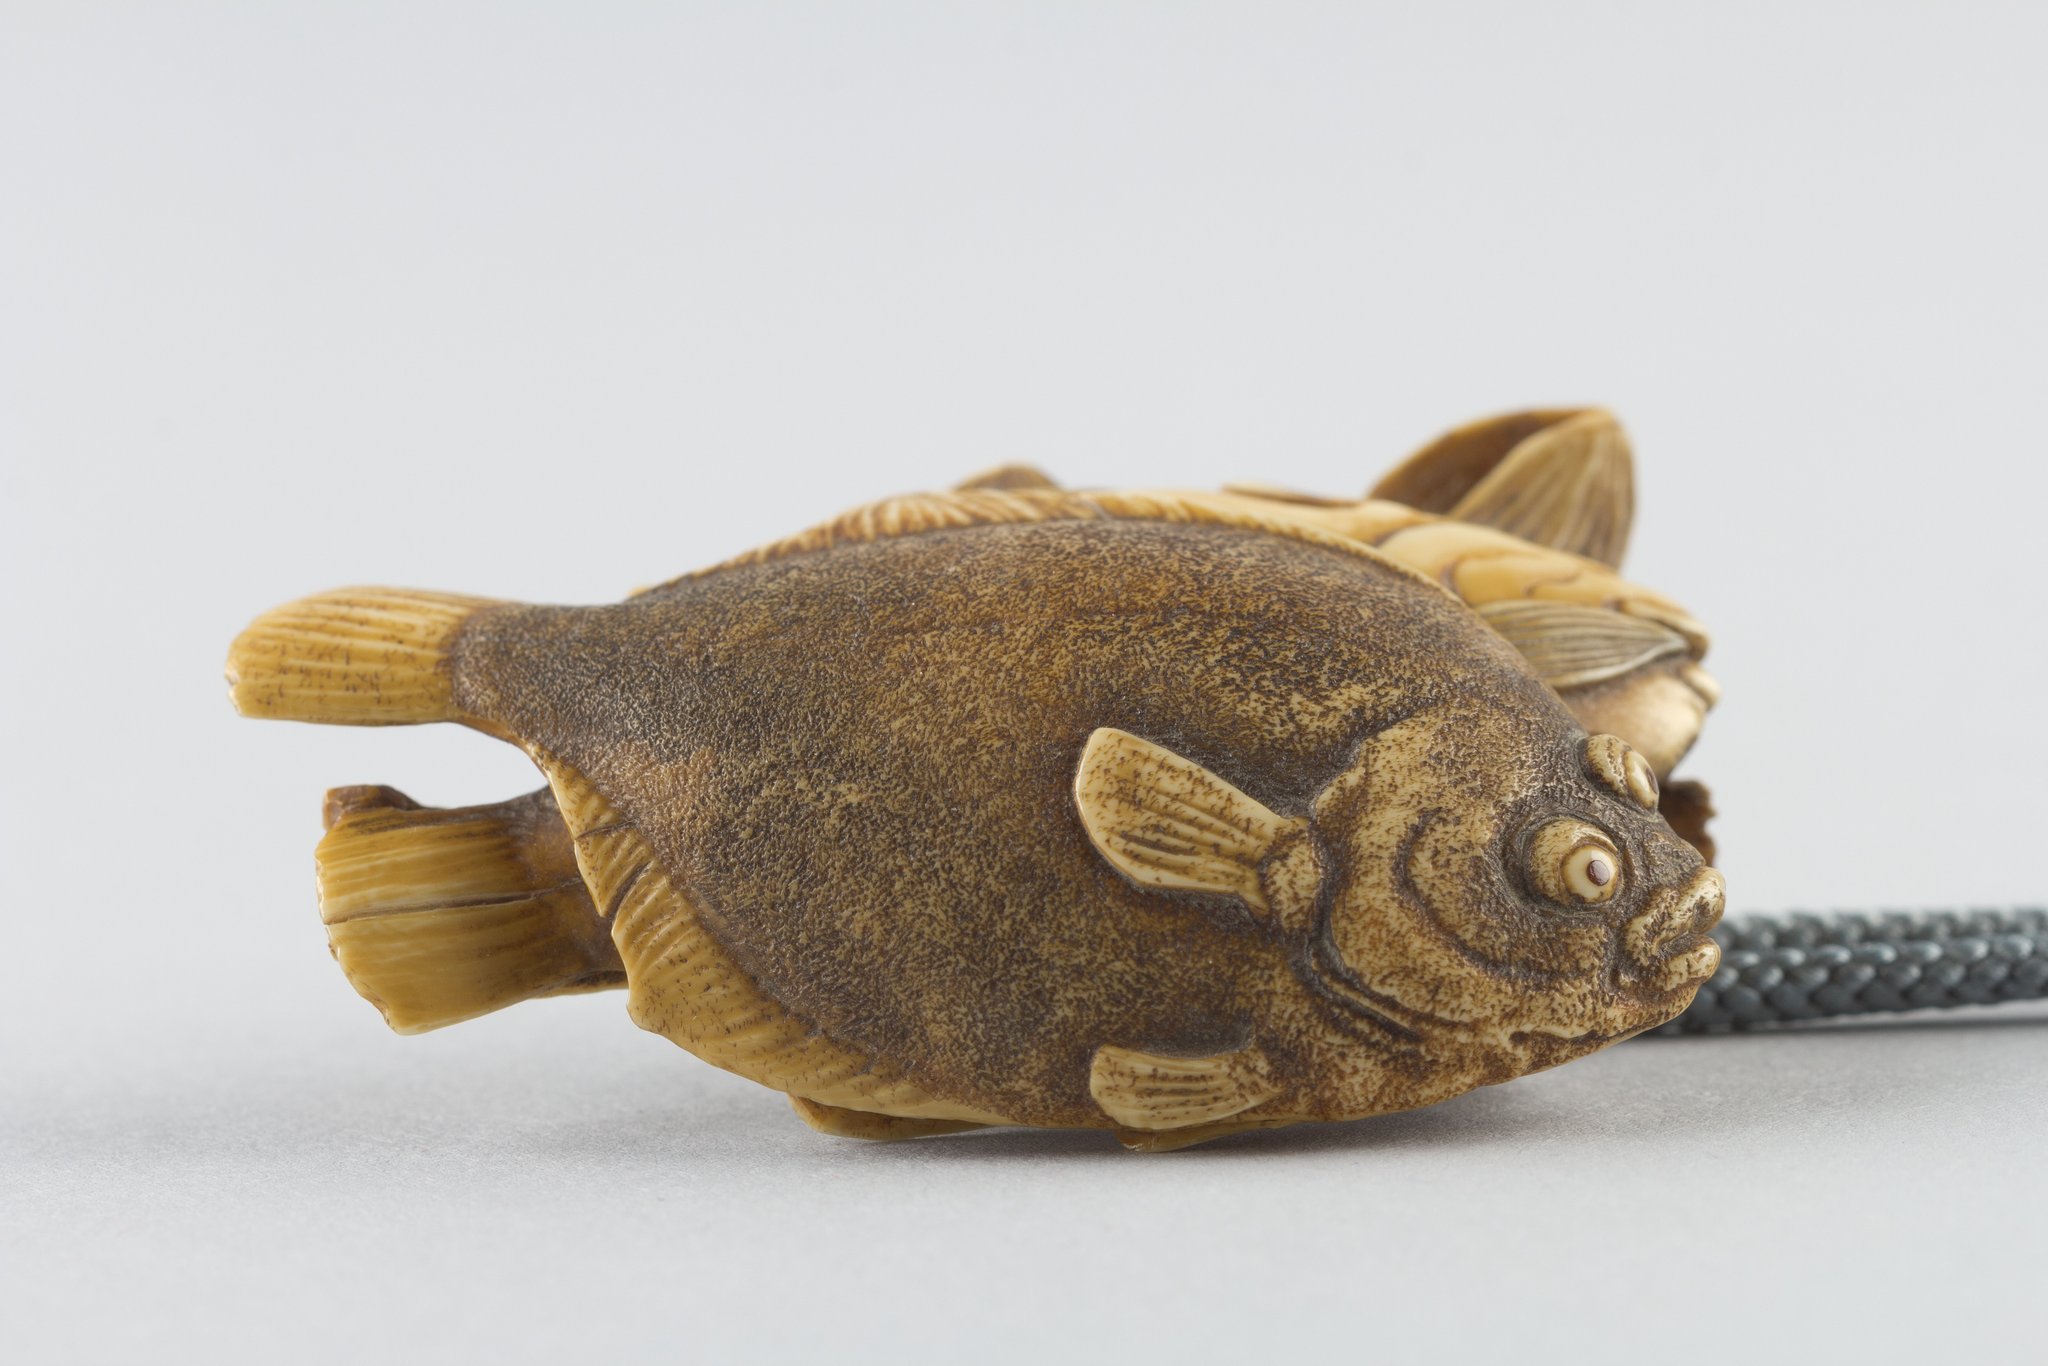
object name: netsuke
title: Netsuke of Fish on Bamboo Leaves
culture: japanese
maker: jugyoku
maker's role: artist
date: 1867-1900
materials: ivory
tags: fish